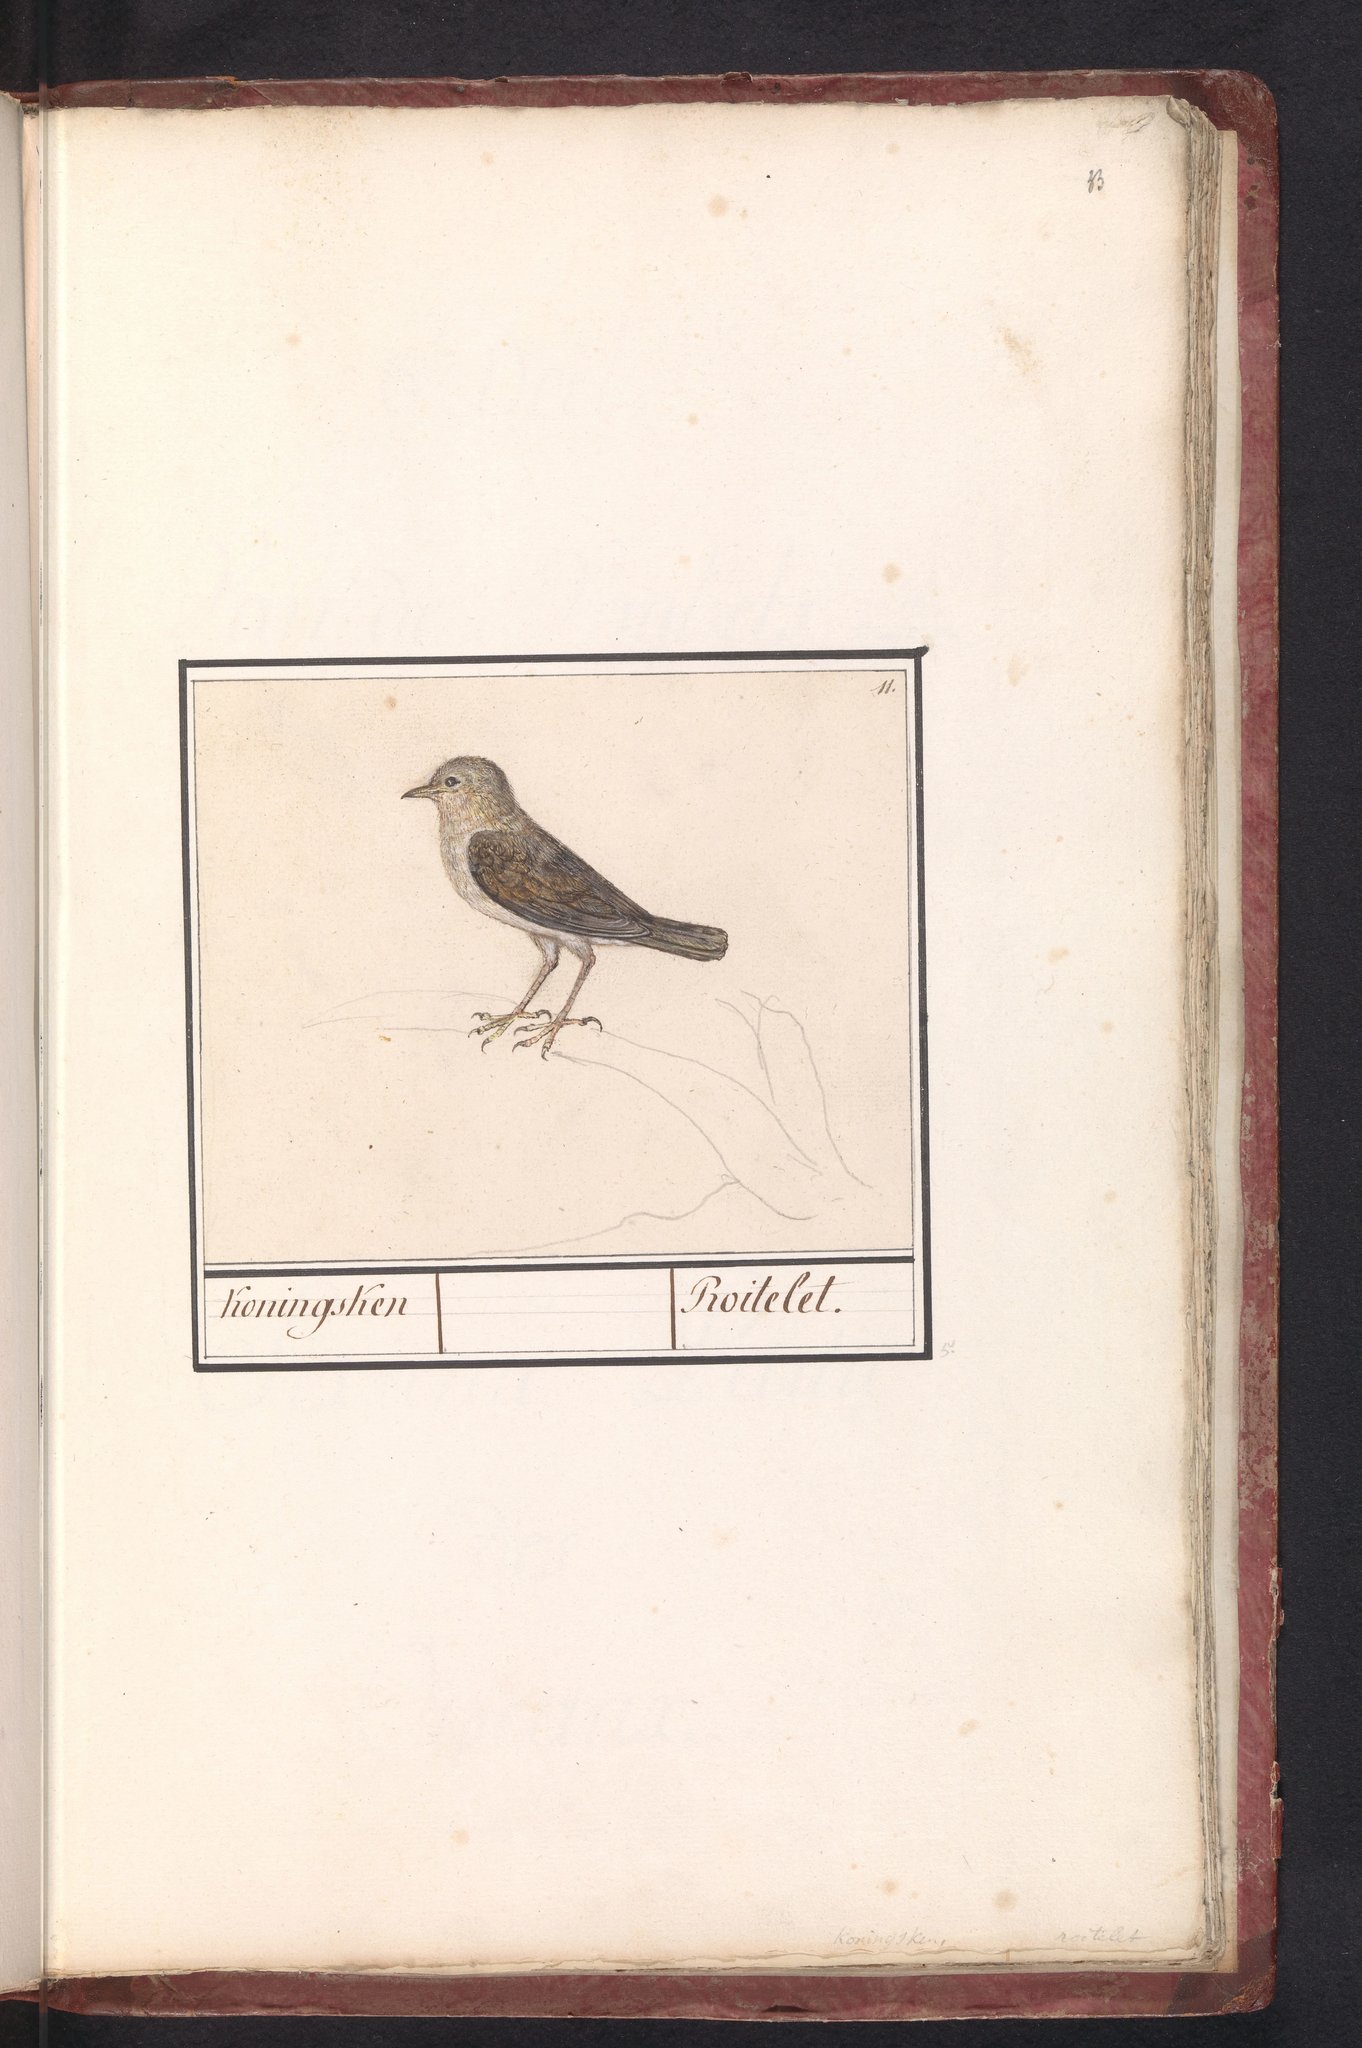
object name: drawing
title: Vogeltje, mogelijk een winterkoninkje (Troglodytes troglodytes)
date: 1596-1610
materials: paint, ink, paper, pencil, watercolor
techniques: brush, pen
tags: song-birds: lark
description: Vogeltje, mogelijk een winterkoninkje. De Franse naam (roitelet) verwijst naar een goudhaantje, wat het zeker niet is. Genummerd rechtsboven: 11. Onderdeel van het tweede album met tekeningen van vogels. Vierde van twaalf albums met tekeningen van dieren, vogels en planten bekend rond 1600, gemaakt in opdracht van keizer Rudolf II. Met toelichting in Nederlands, Latijn en Frans.